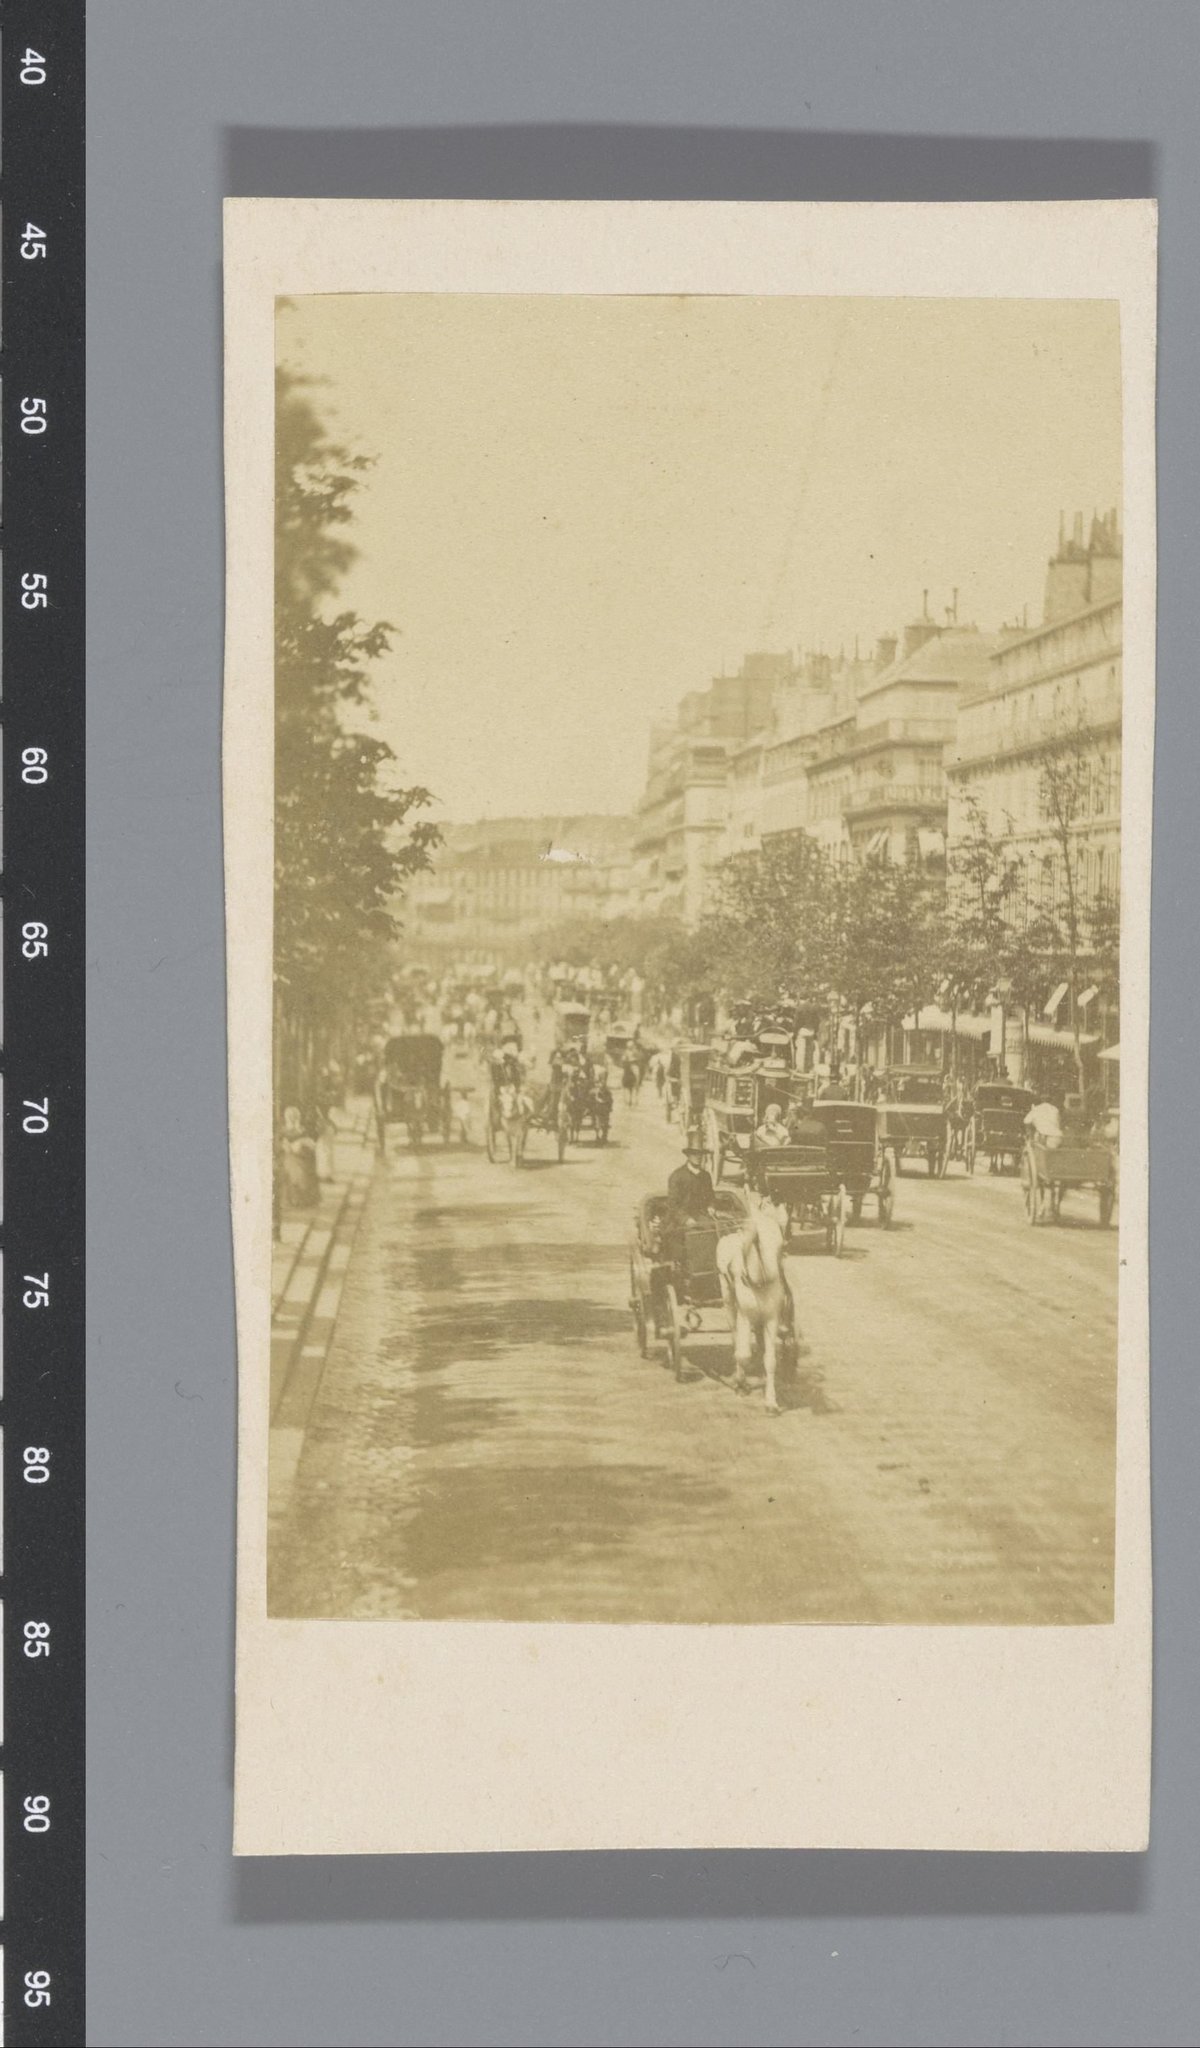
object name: carte de visite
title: Boulevard Montmartre, Parijs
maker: Anonymous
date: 1865-1870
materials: cardboard, paper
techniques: albumen print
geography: paris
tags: street (+ city(-scape) with figures, staffage)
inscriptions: inscription: ‘Bd. Montmartre/ Paris’